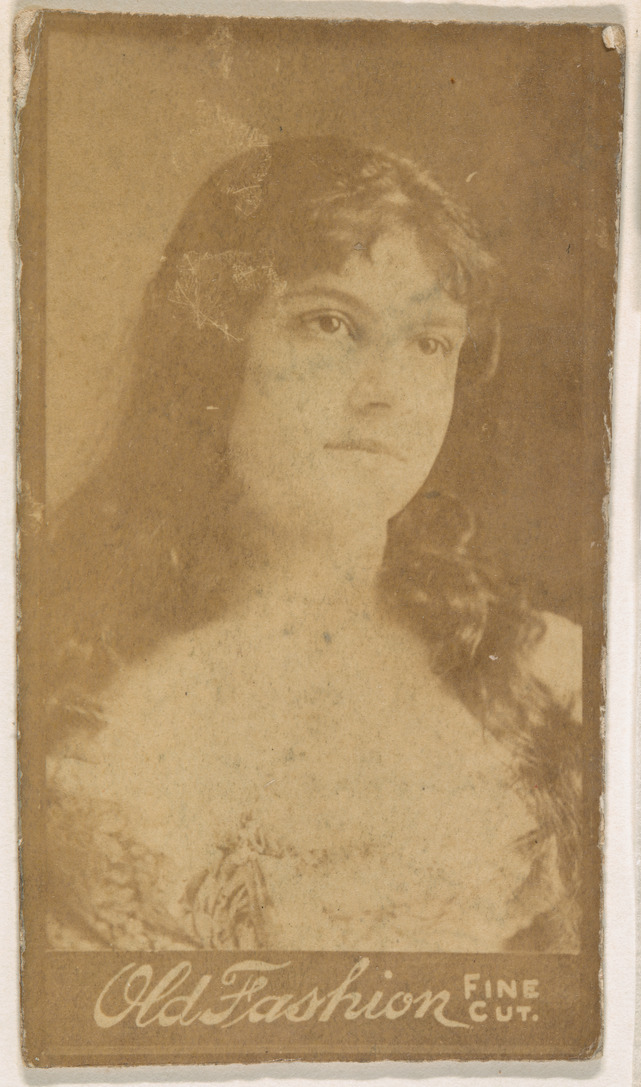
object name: photograph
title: Actress with long hair, from the Actresses series (N664) promoting Old Fashion Fine Cut Tobacco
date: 1888-1890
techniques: albumen silver print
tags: portraits,women,actresses